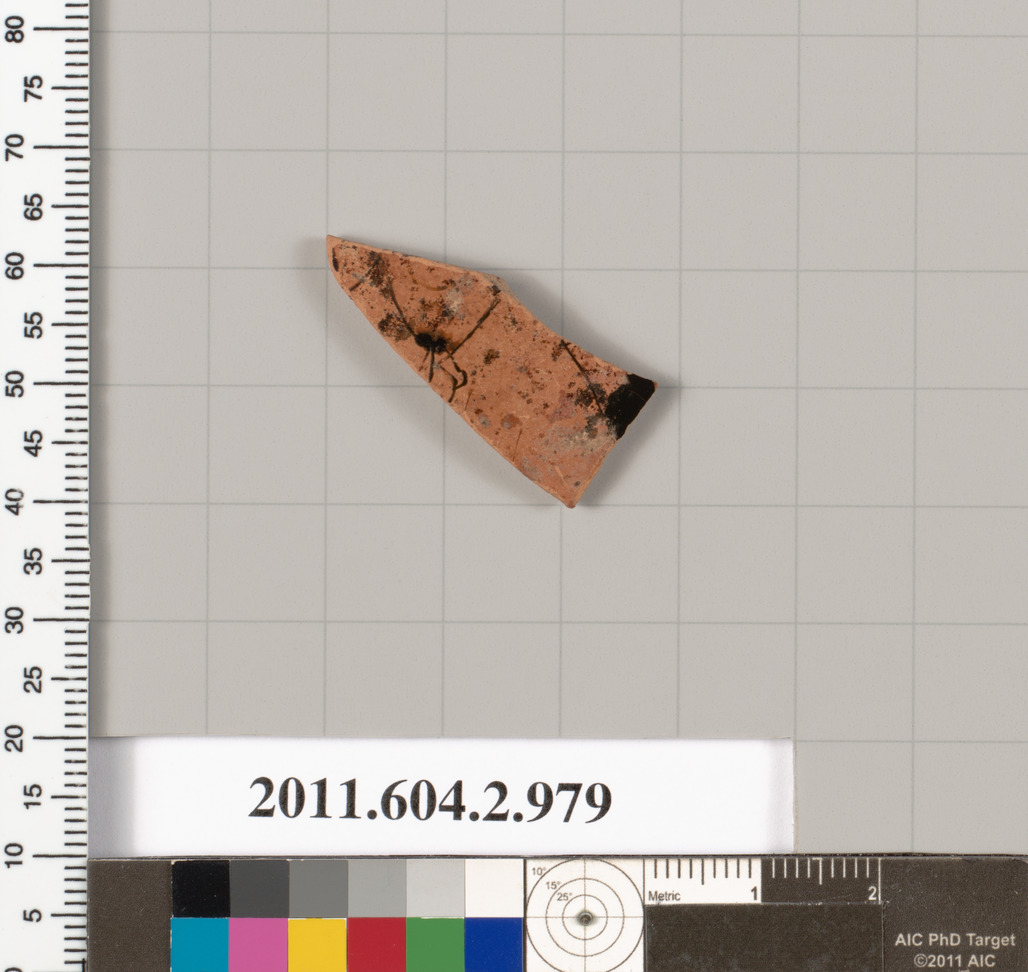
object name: oinochoe fragment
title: Terracotta fragment of an oinochoe (jug)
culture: greek, attic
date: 475-451 BCE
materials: terracotta